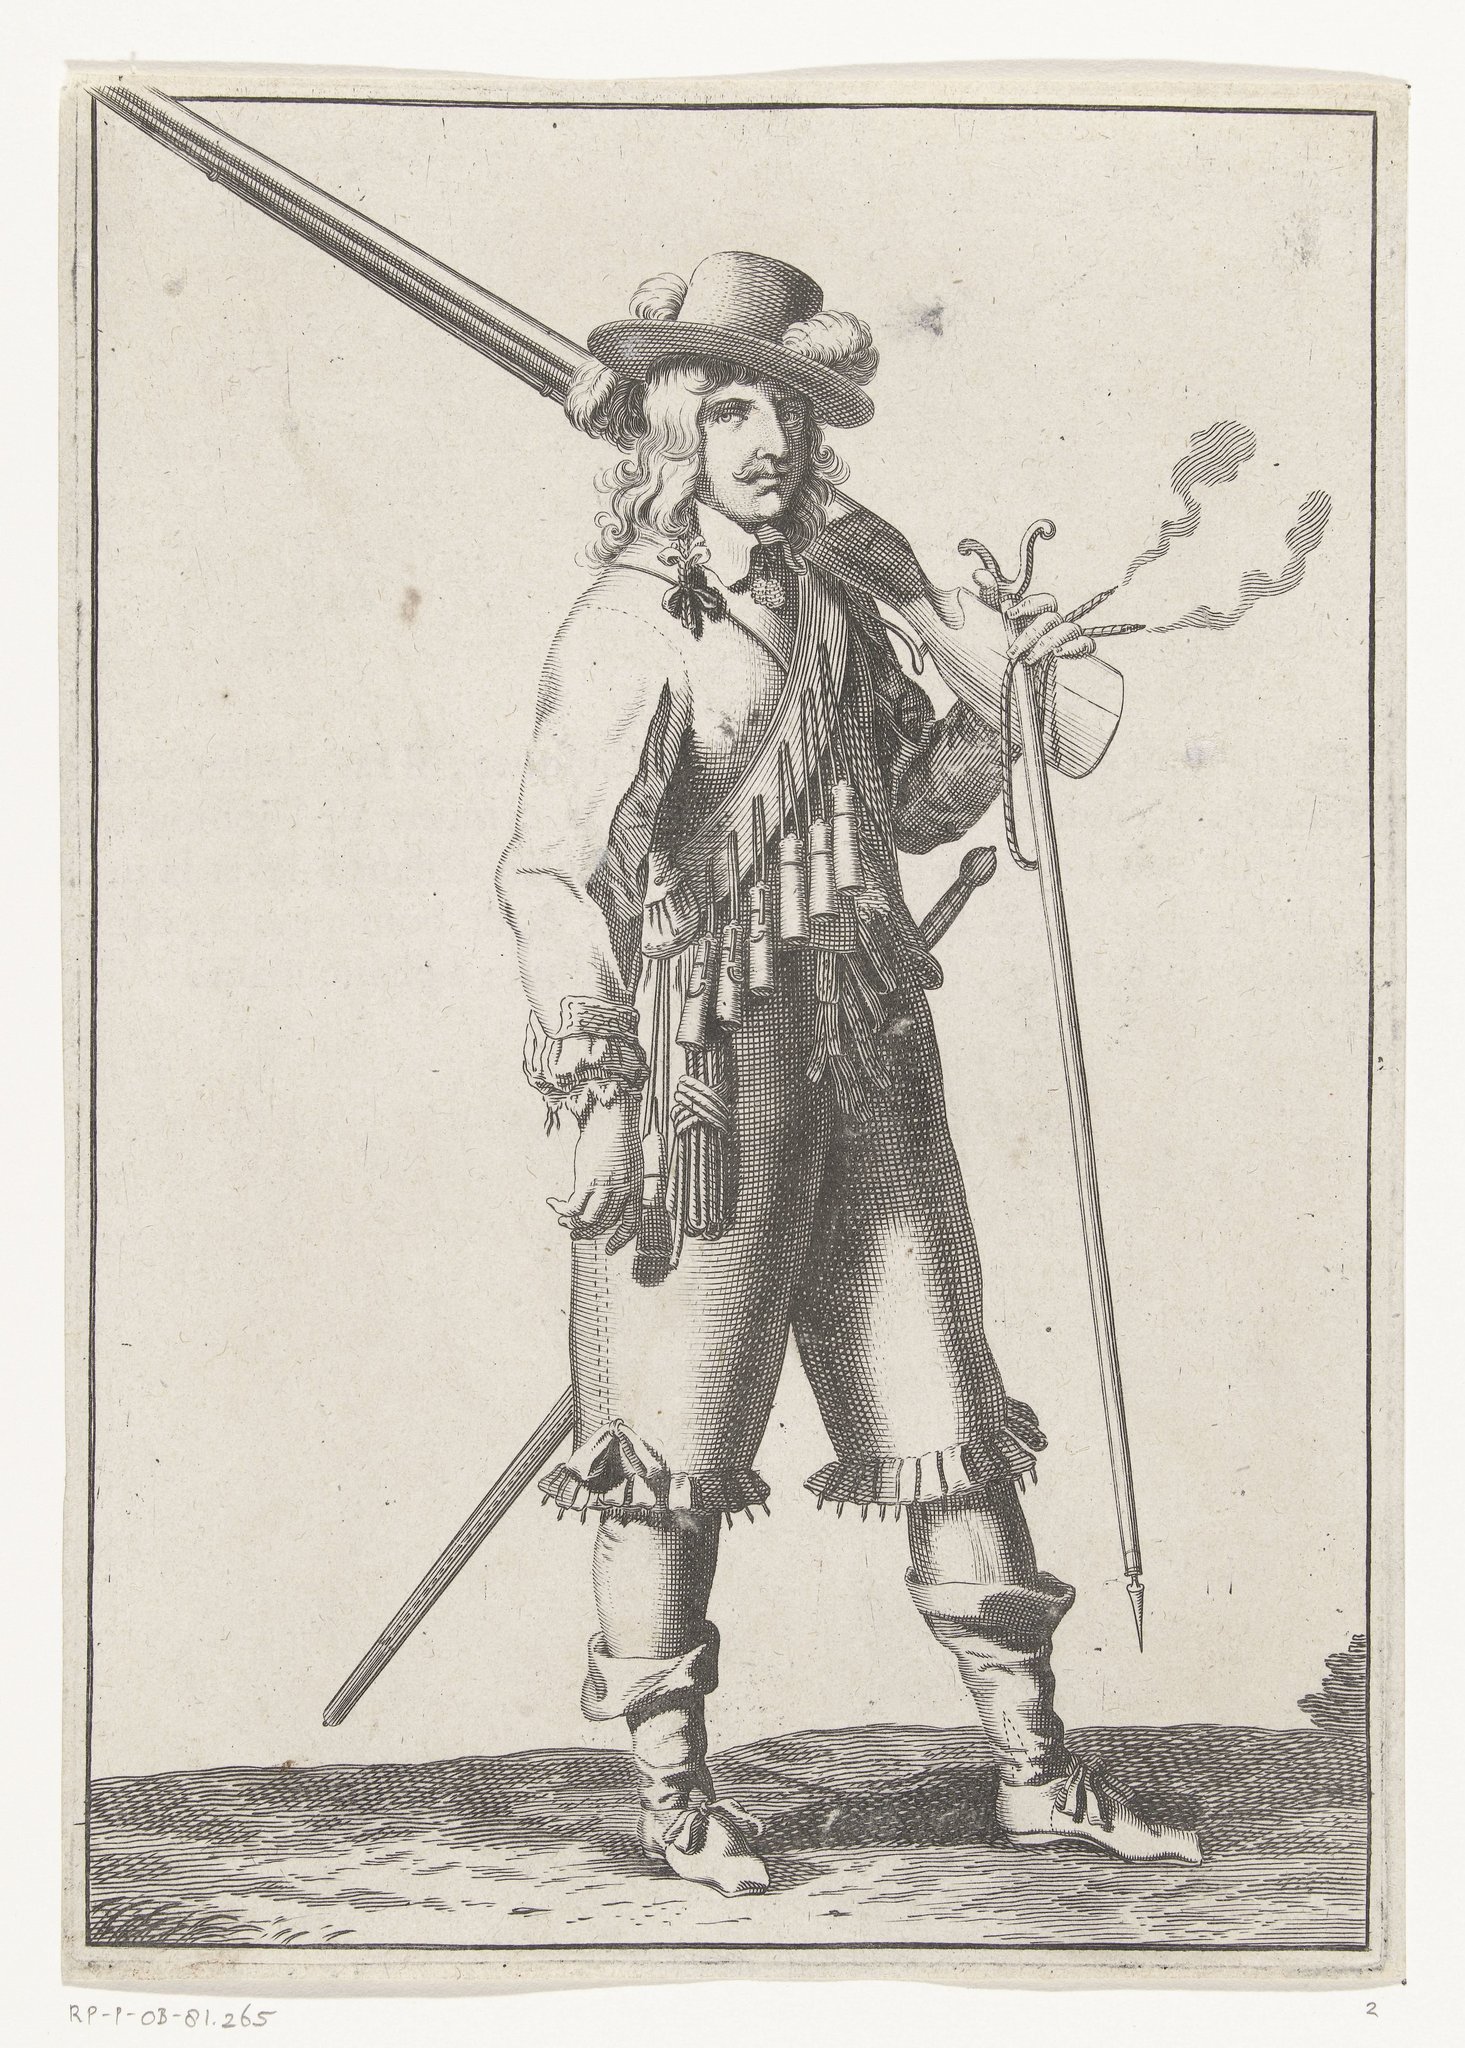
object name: print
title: Soldaat die zijn musket op zijn linkerschouder draagt en zijn furket in zijn linkerhand vasthoudt, ca. 1645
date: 1645-1647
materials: paper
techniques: engraving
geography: southern netherlands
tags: handling of weapons ~ military training, weapons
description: Een soldaat, ten voeten uit, naar rechts, met een musket (een bepaald type vuurwapen) steunend op zijn linkerschouder. In zijn linkerhand behalve de kolf van het musket ook een furket (musketvork) en een brandende lont, ca. 1645. Bedrukt op achterzijde met tekst in het Frans. Vrij naar plaat 2 in de instructies voor het hanteren van het musket in de Wapenhandelinghe van J. de Gheyn. Krijgswezen rond 1600.